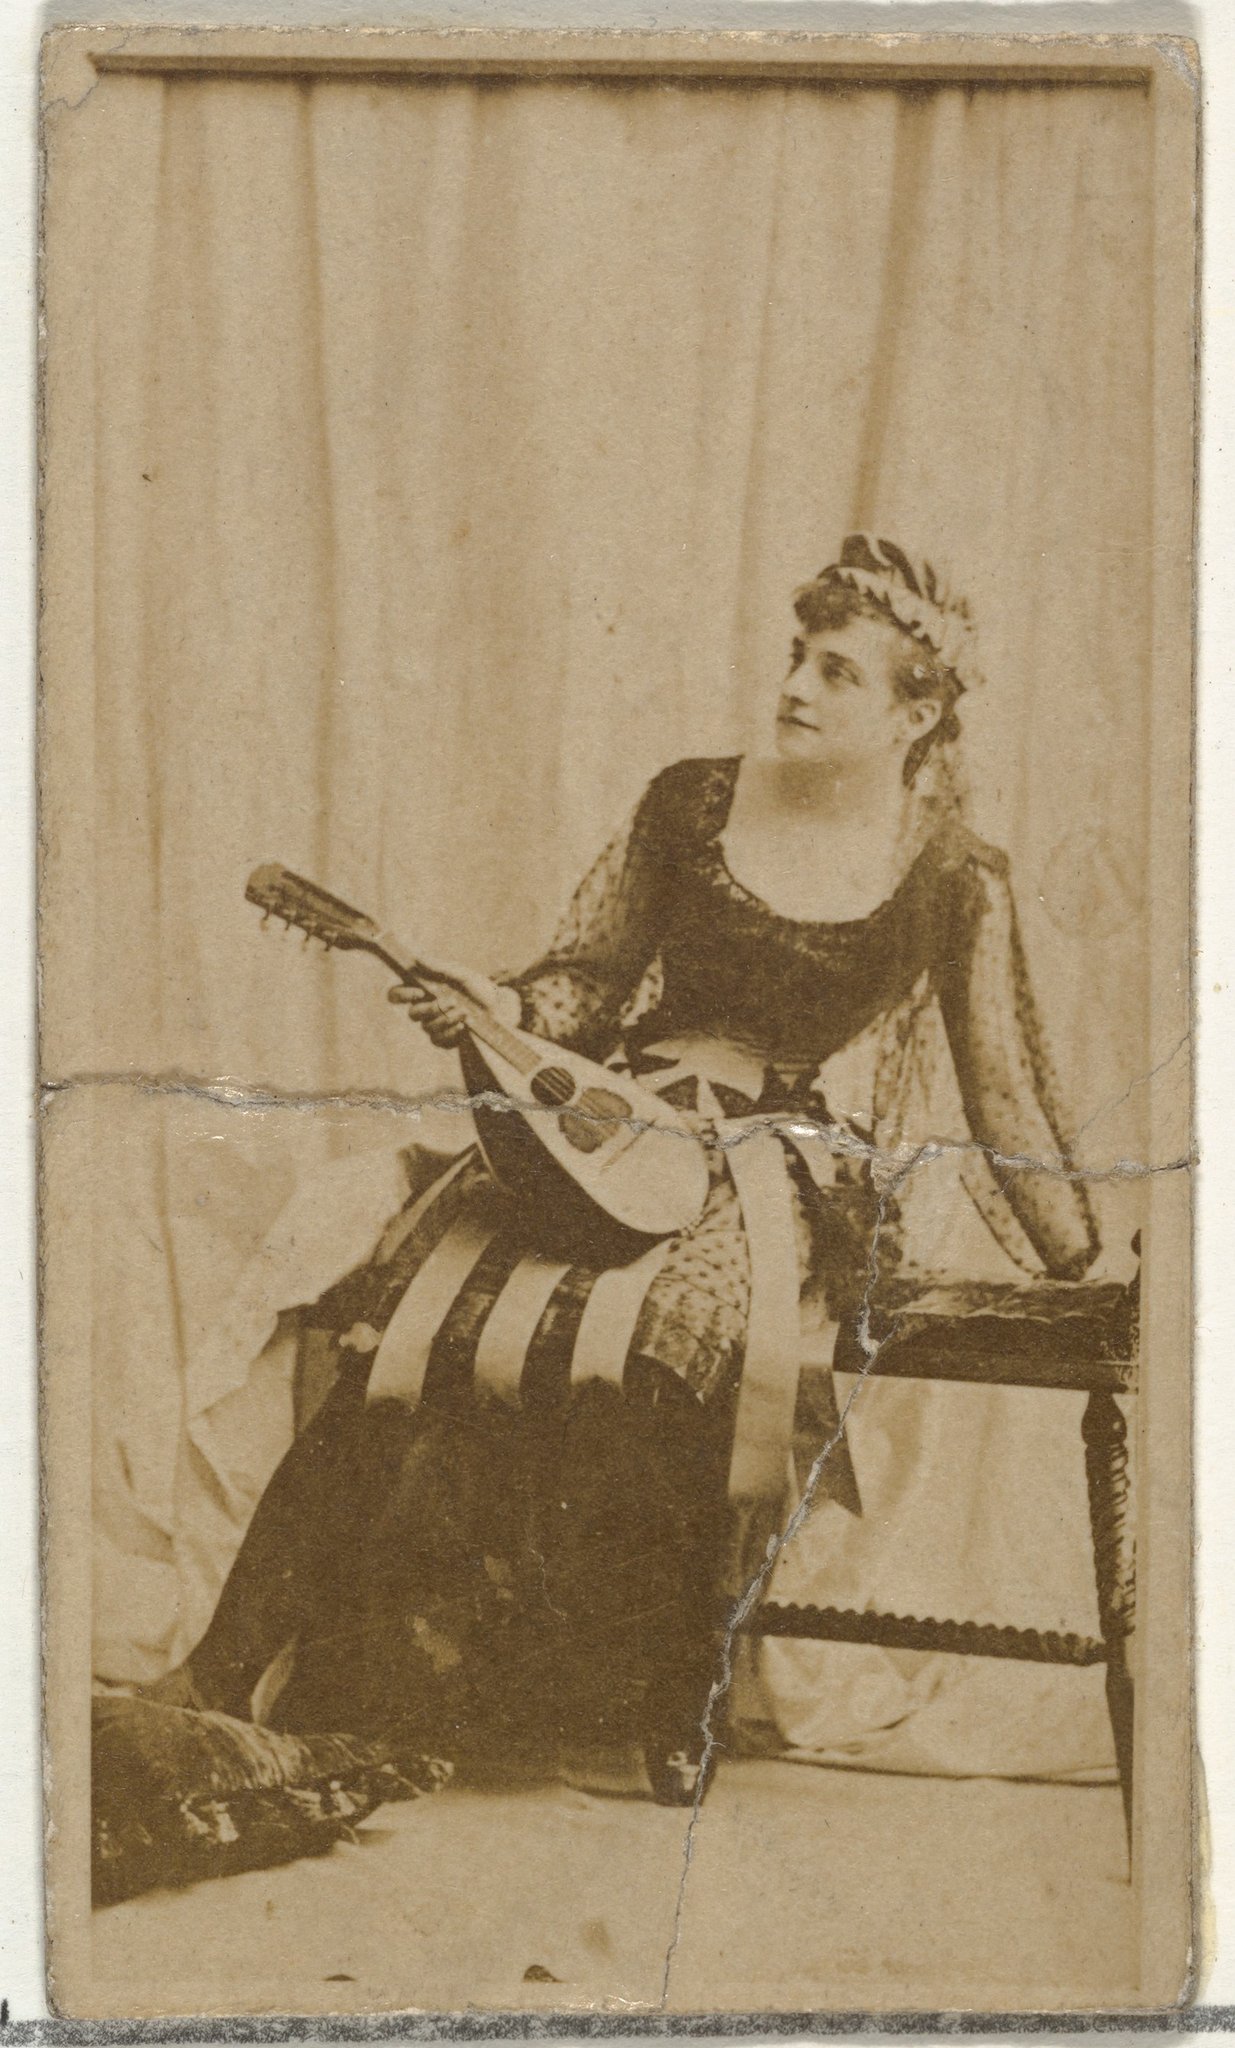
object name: photograph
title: [Actress holding mandolin], from the Actors and Actresses series (N145-8) issued by Duke Sons & Co. to promote Duke Cigarettes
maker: w. duke, sons & co.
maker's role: publisher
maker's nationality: american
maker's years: 1870-1920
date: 1891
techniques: albumen silver print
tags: women,actresses